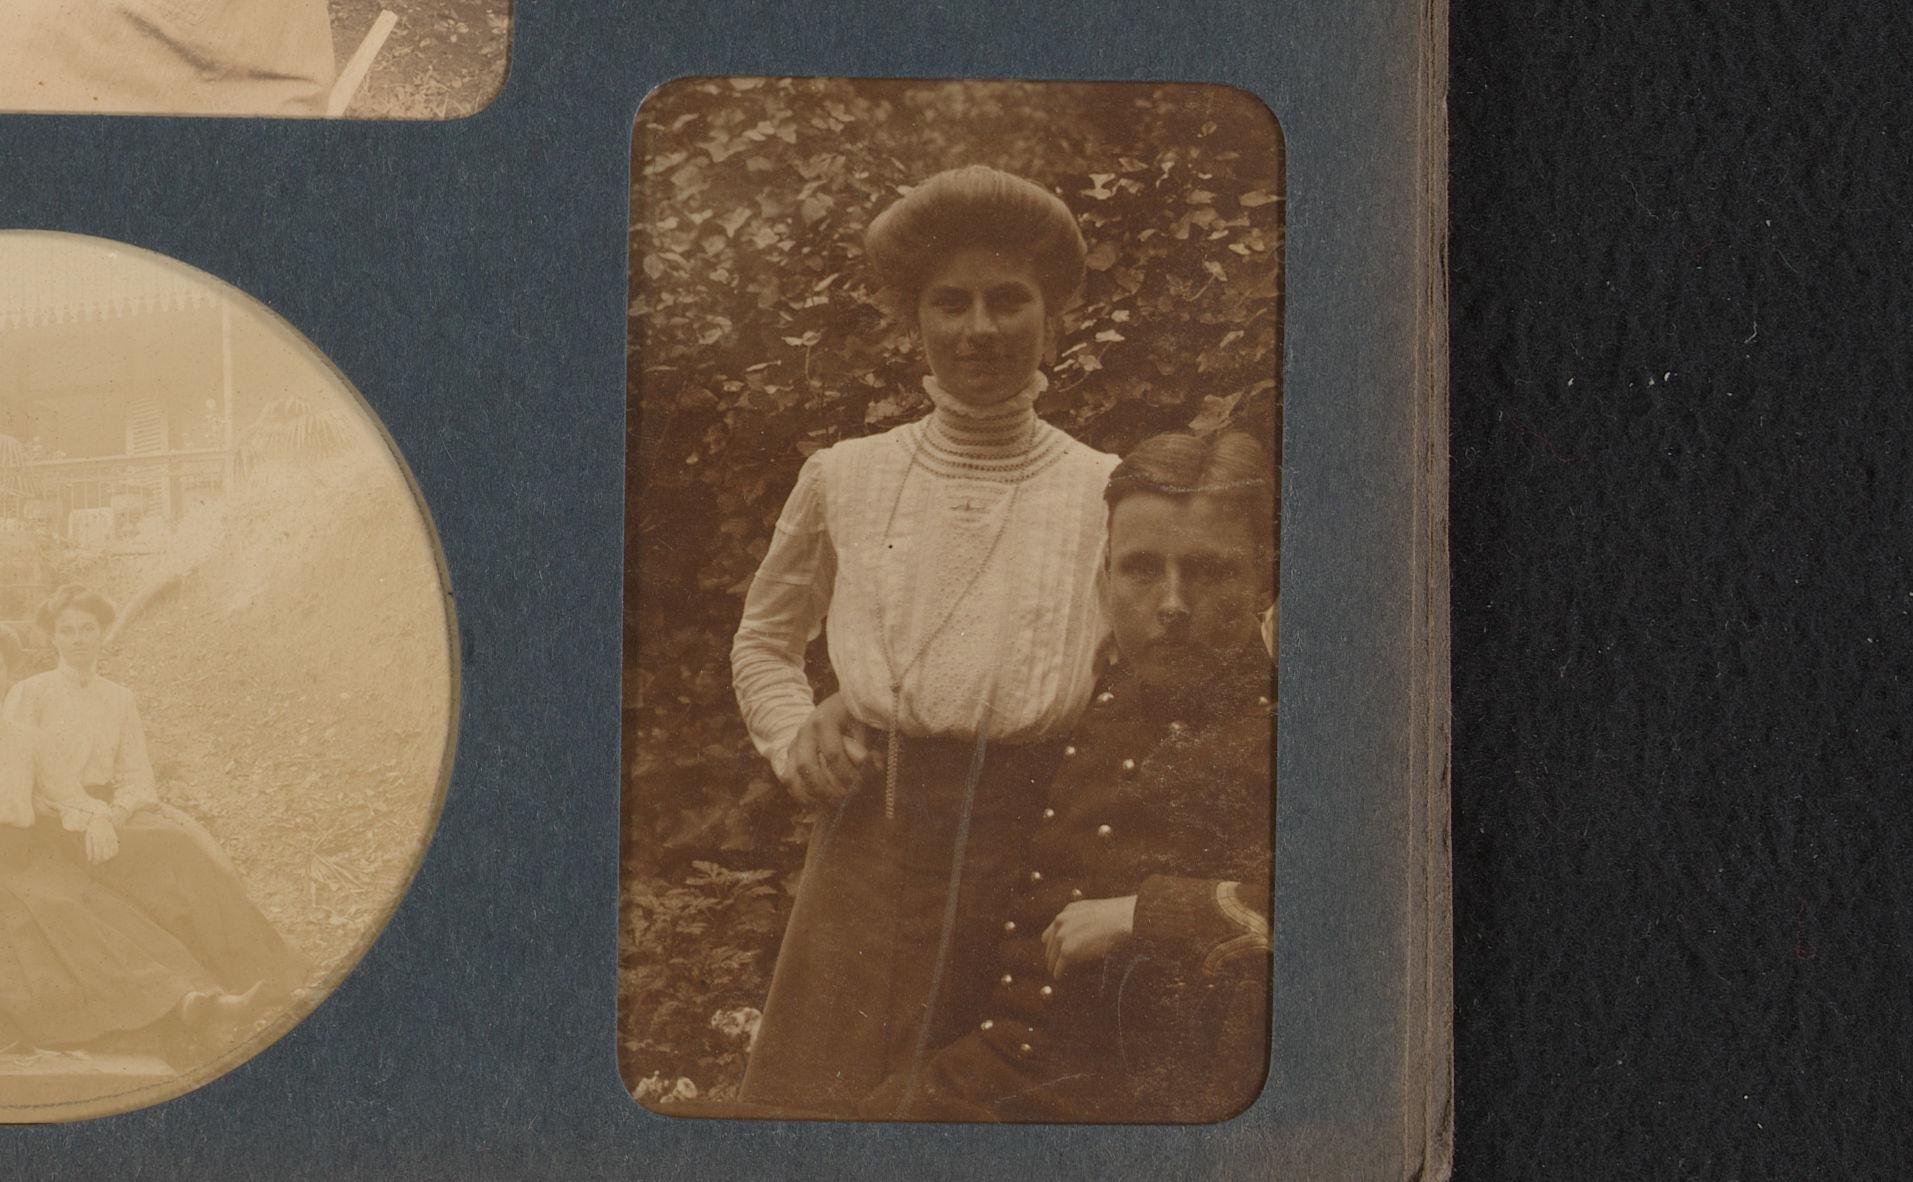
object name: photograph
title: Dubbelportret van Tjuut en Carel Hellendoorn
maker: Anonymous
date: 1911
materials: paper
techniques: gelatin silver print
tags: adolescent, young woman, maiden, youth, adolescent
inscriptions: inscription: ‘Tjuut en Carel’